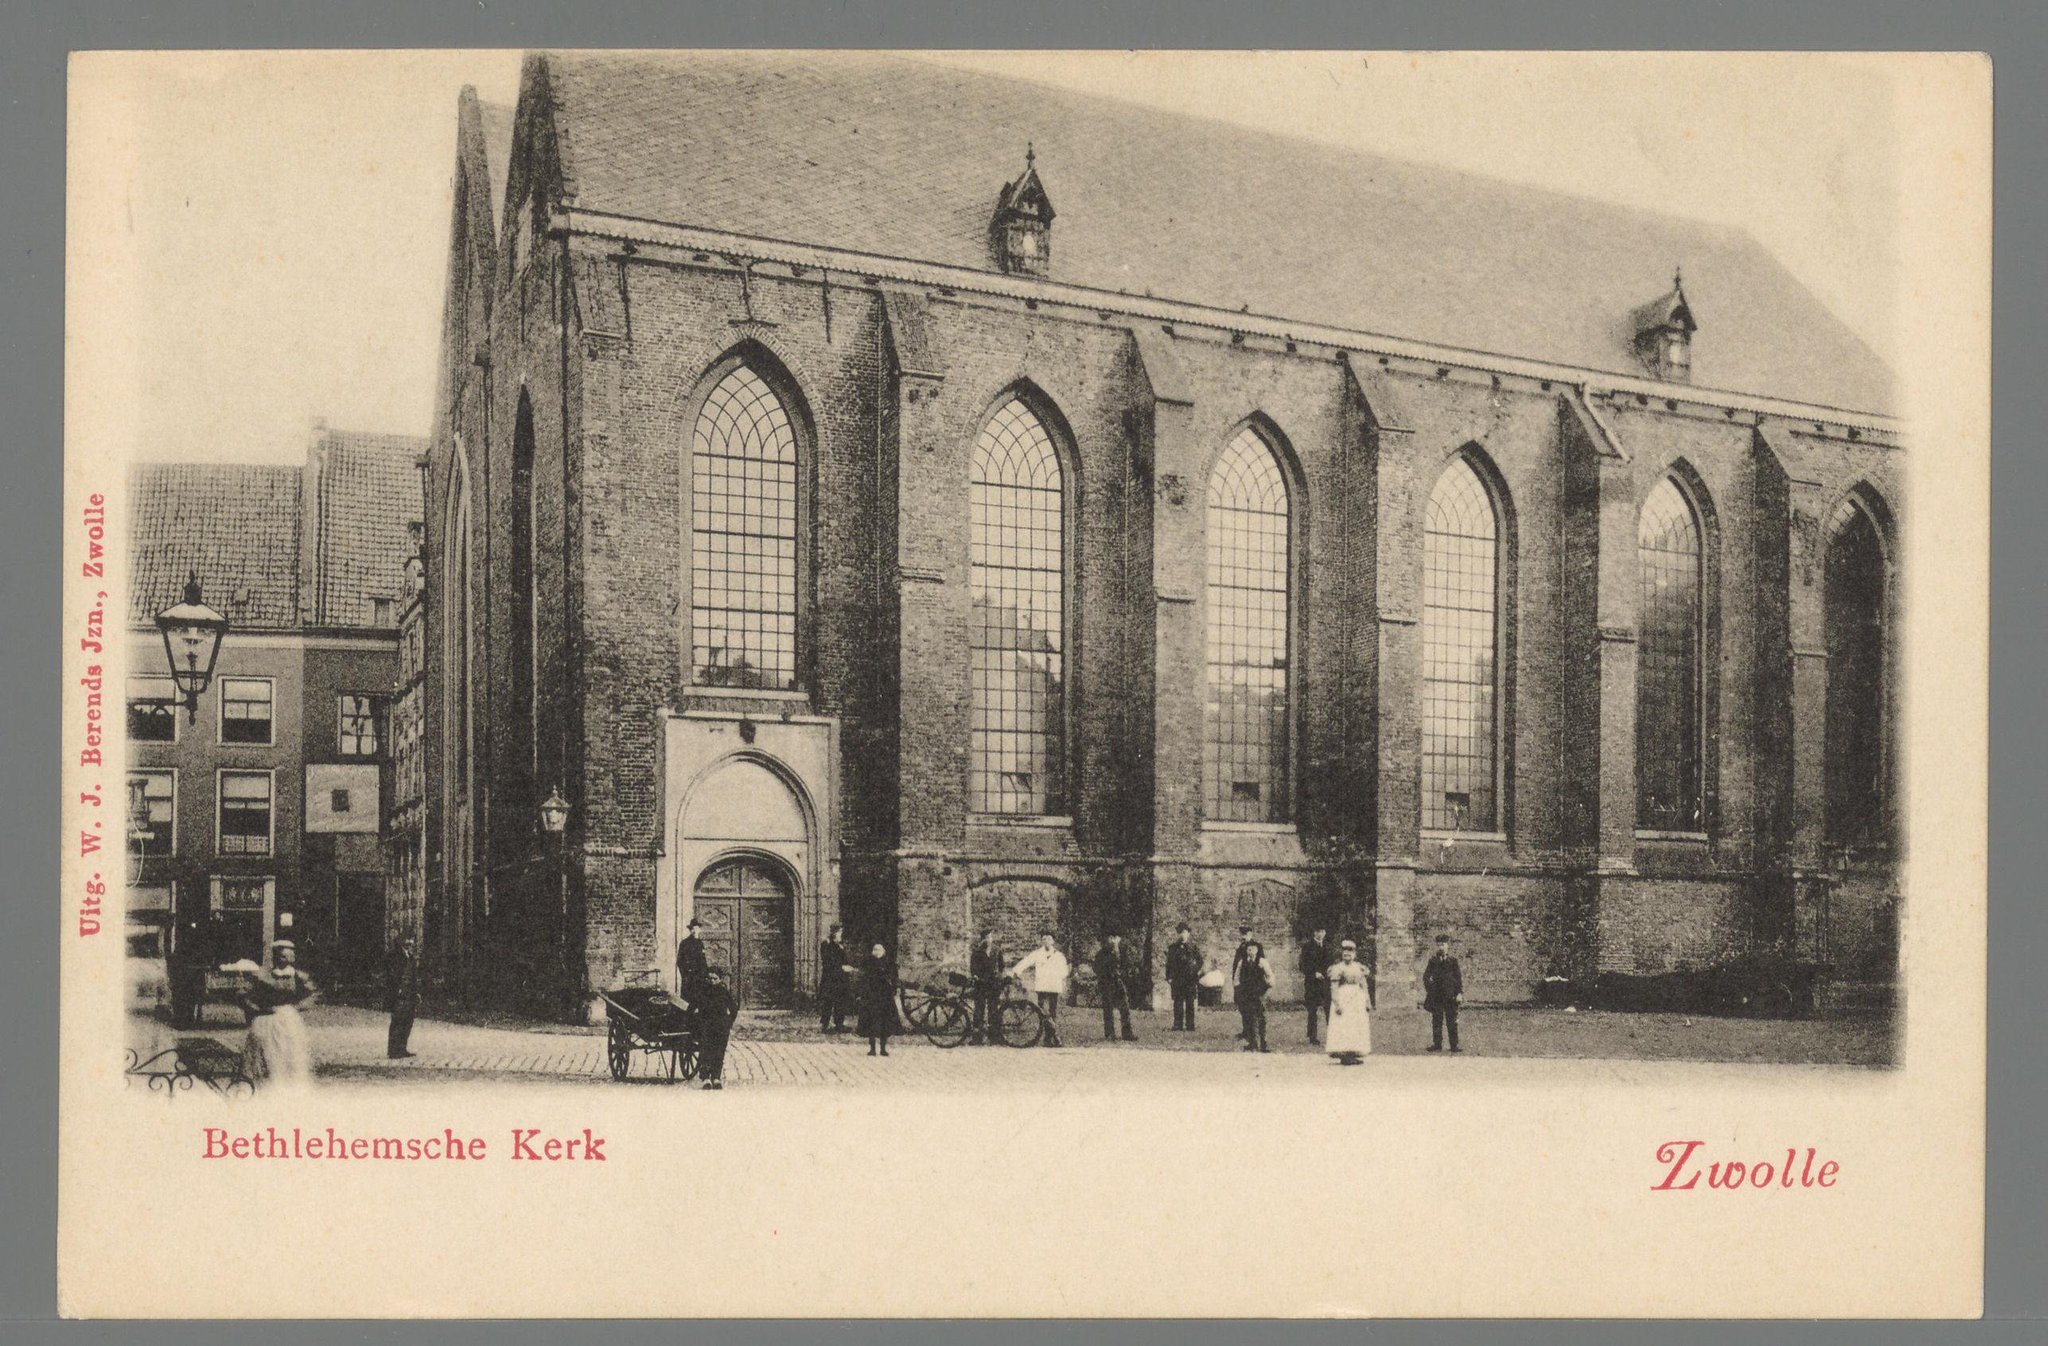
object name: photomechanical print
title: Bethlehemsche Kerk. Zwolle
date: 1892-1905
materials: cardboard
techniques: photograph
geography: zwolle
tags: church (exterior)